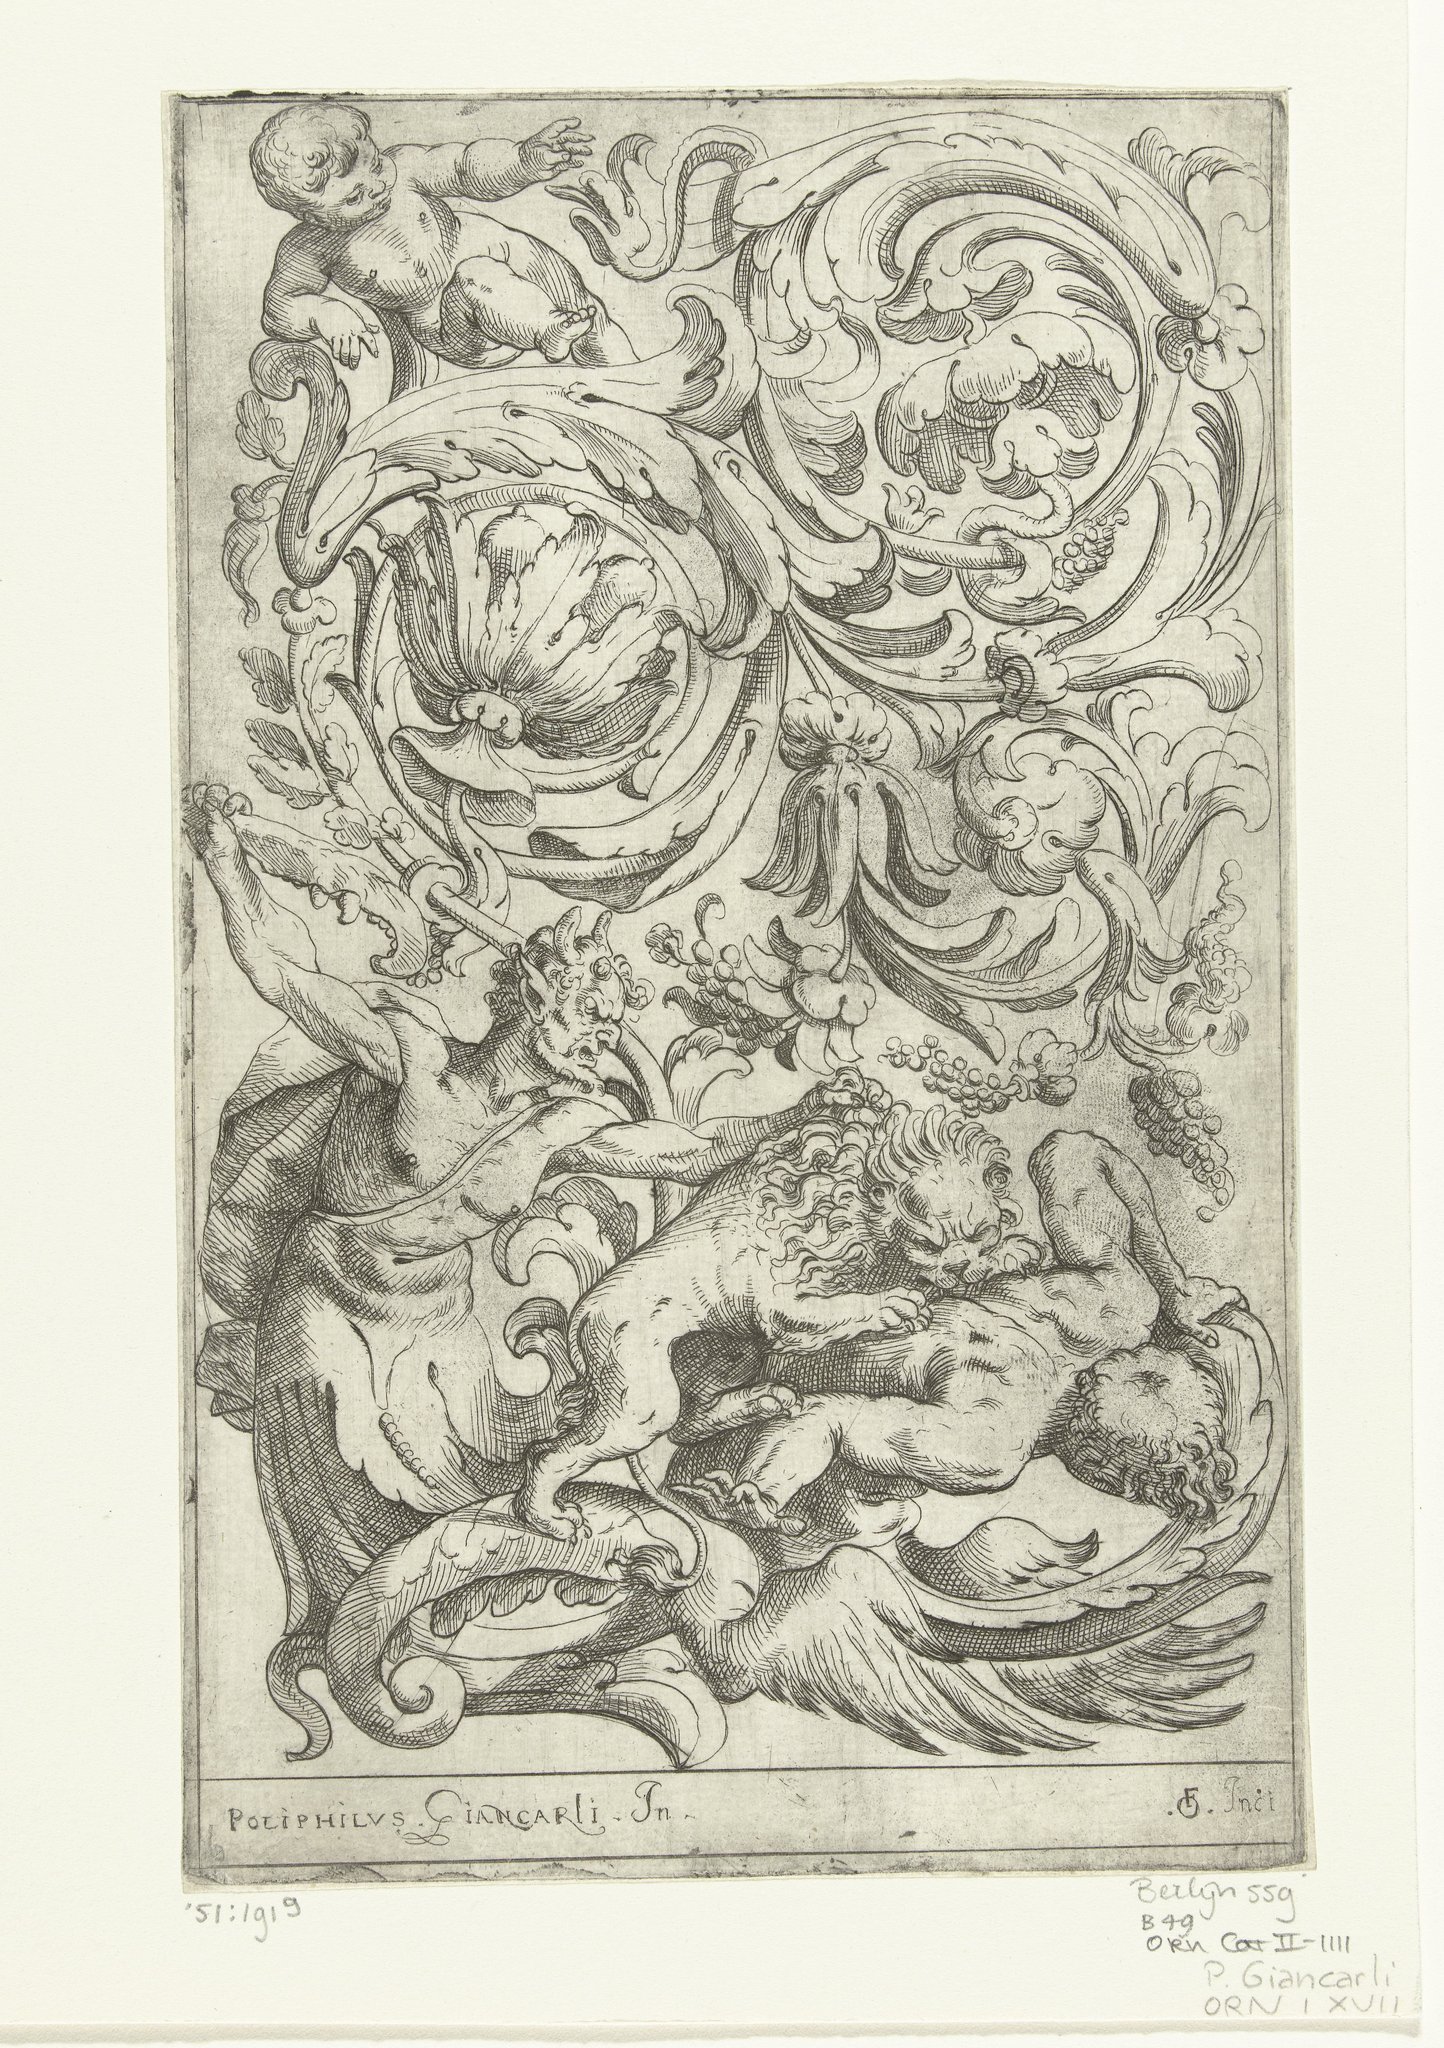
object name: print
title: Sater en man die gebeten wordt door leeuw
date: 1625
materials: paper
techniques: etching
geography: venice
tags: satyr(s) (in general), beasts of prey, predatory animals: lion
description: Het onderlichaam van de man die gebeten wordt loopt uit in een bladrank met bloemen. Blad uit serie van 10 bladen met verticale panelen vol bladranken, figuren en dieren.